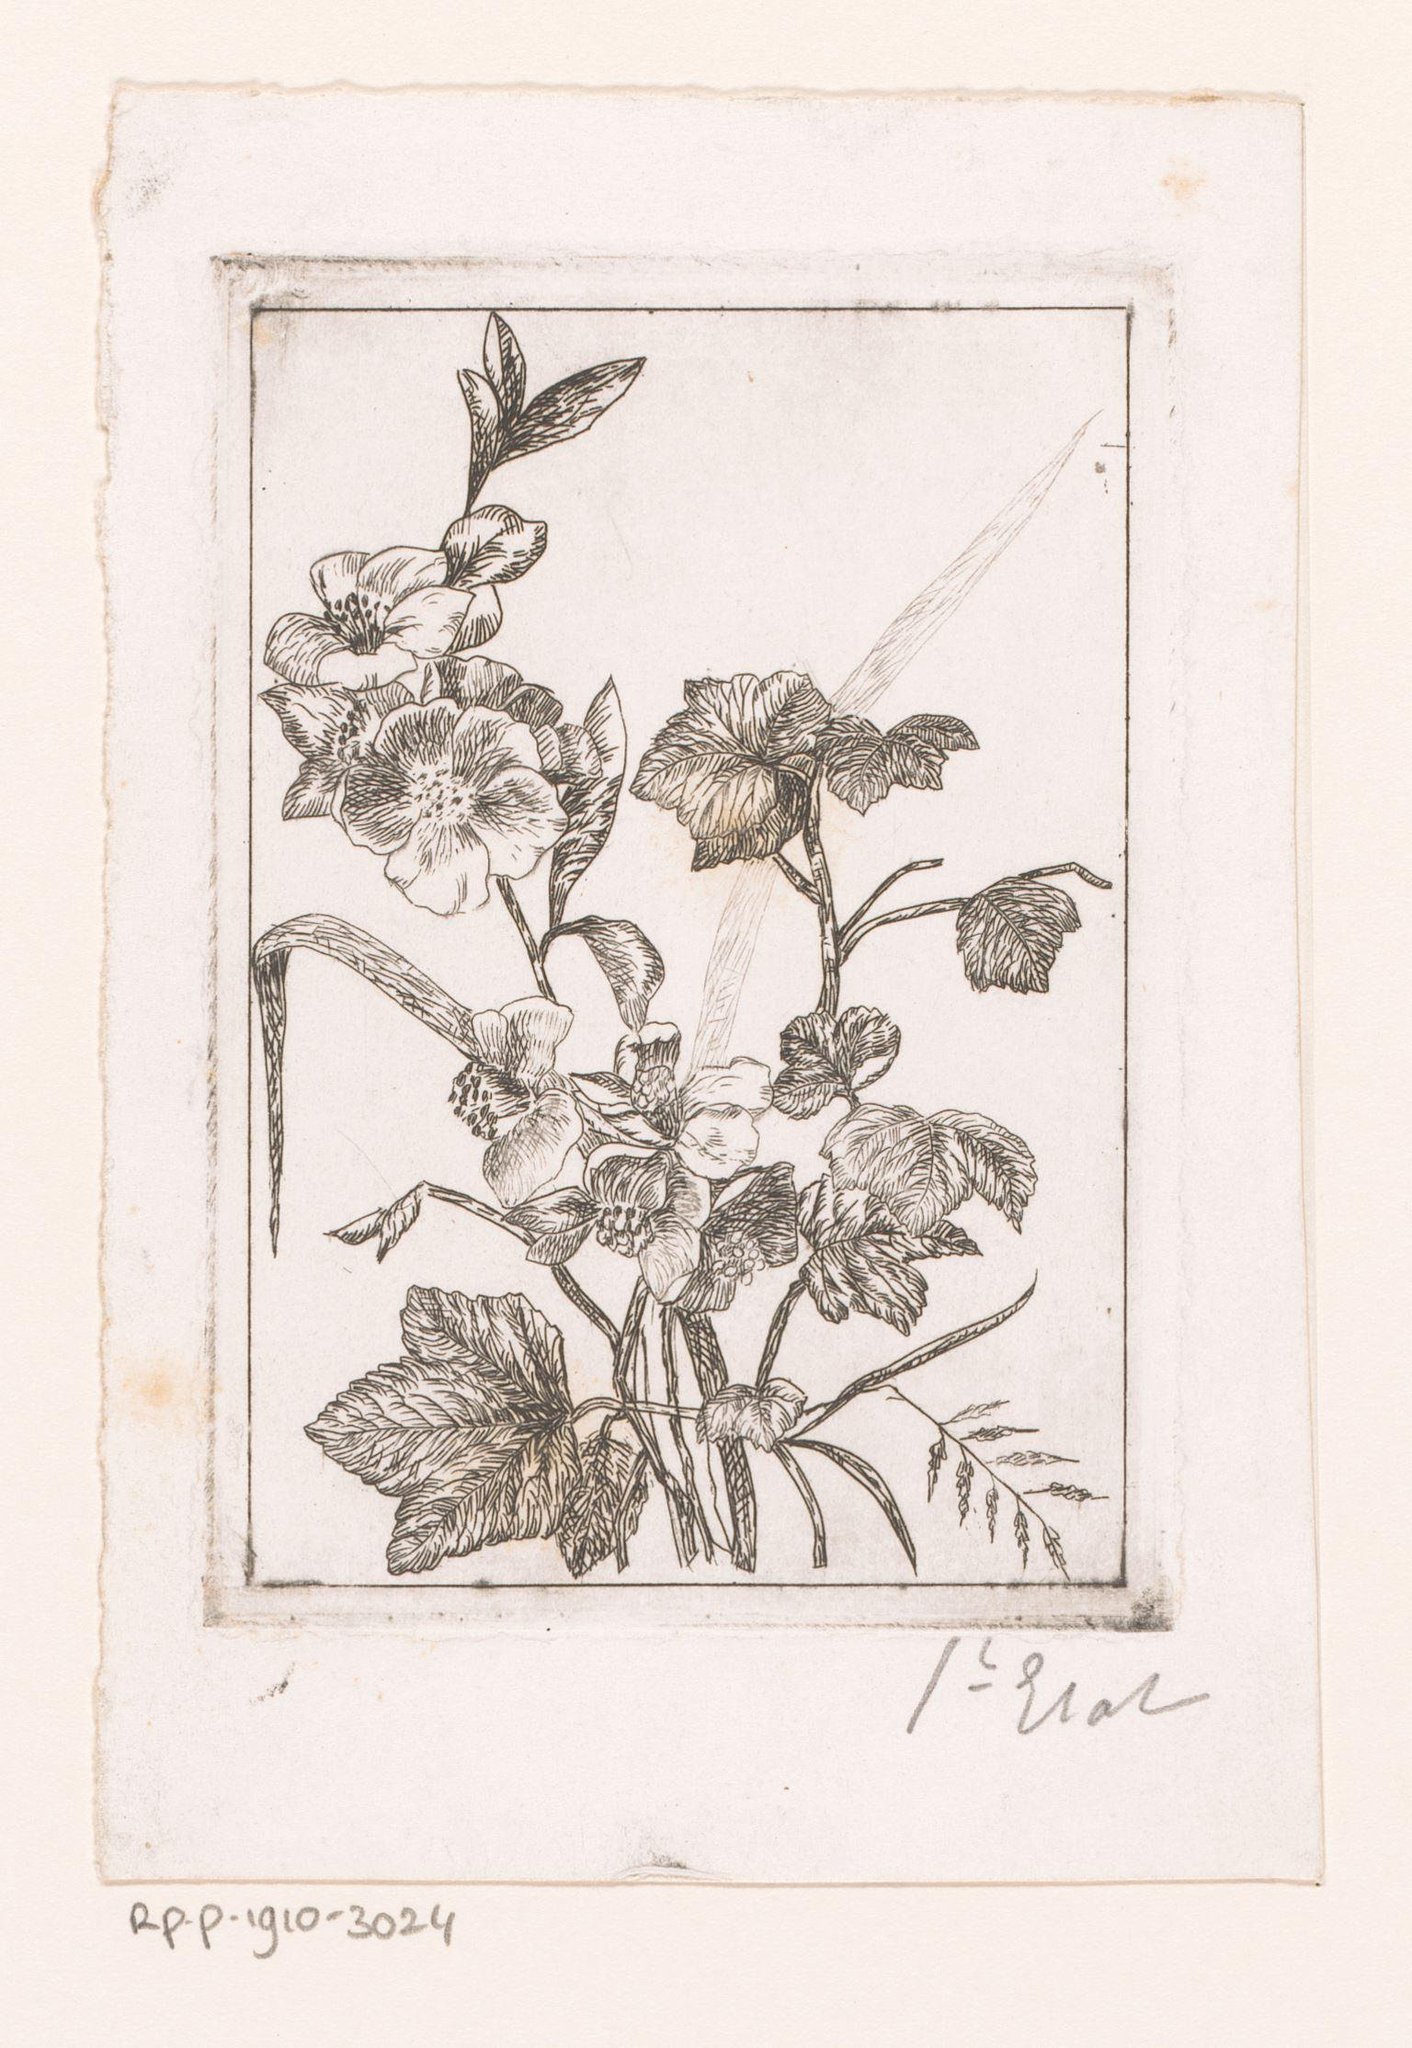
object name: print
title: Bloemen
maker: louise elsen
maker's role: print maker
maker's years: 1853-1937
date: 1860-1900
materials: paper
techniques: etching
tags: flowers, still life of plants, flowers and fruit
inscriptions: collector's mark: Lugt 2228